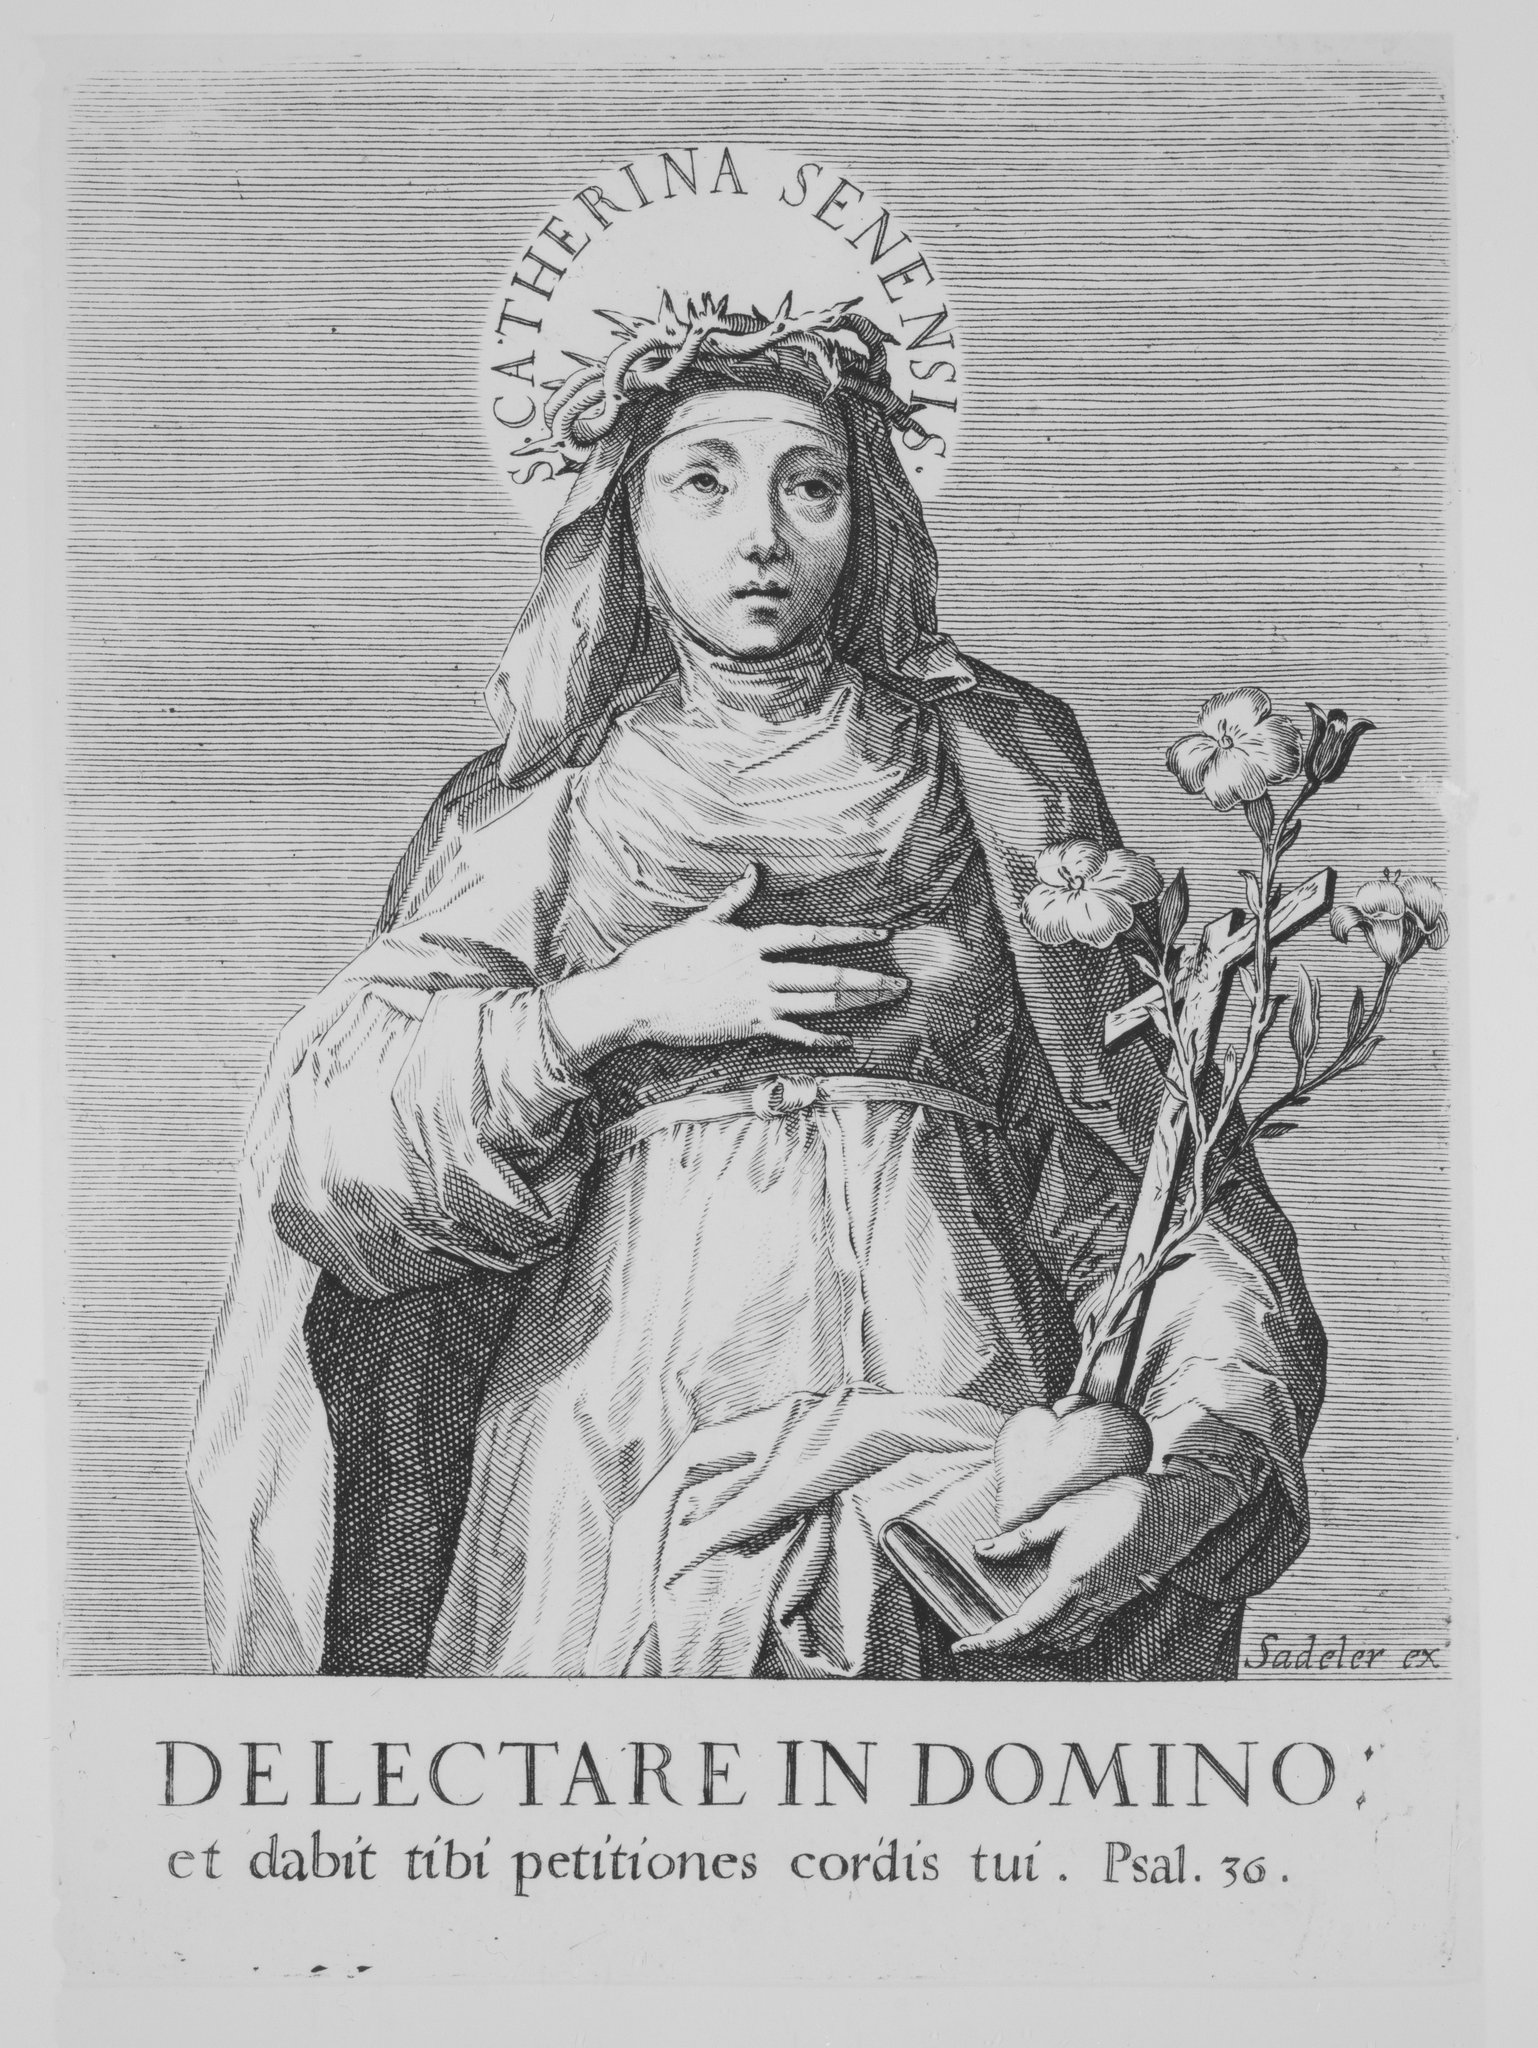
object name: print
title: Saint Catherine of Siena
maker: Anonymous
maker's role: artist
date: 1534-1666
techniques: etching